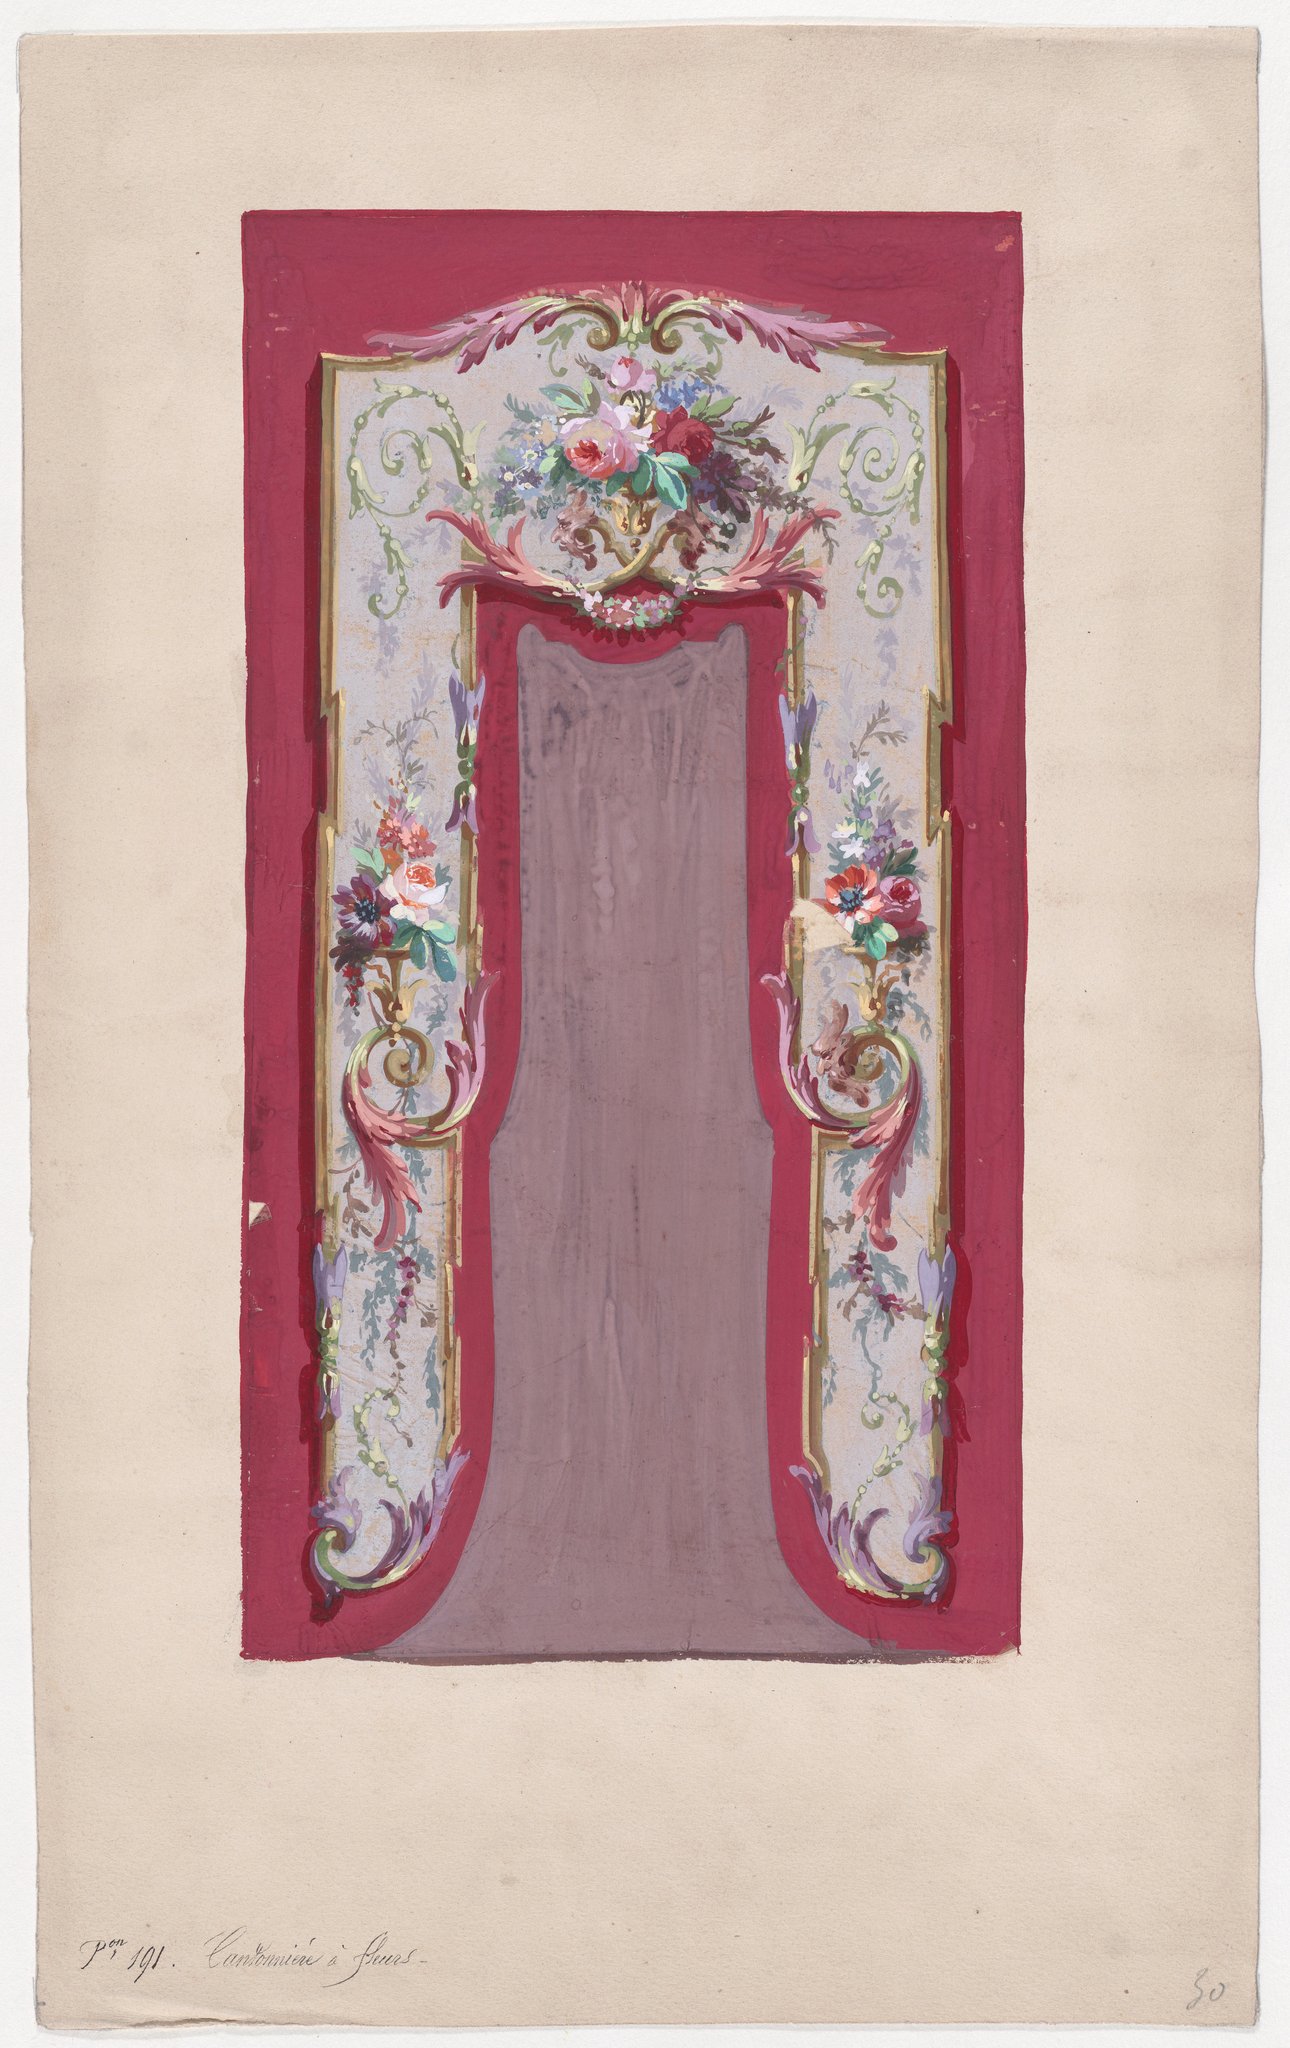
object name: drawing ornament architecture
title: Design for a Valance with Bundles and Garlands of Flowers and Leaves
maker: anonymous, french, 19th century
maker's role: designer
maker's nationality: french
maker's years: 1800-1900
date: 1870-1900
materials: watercolor